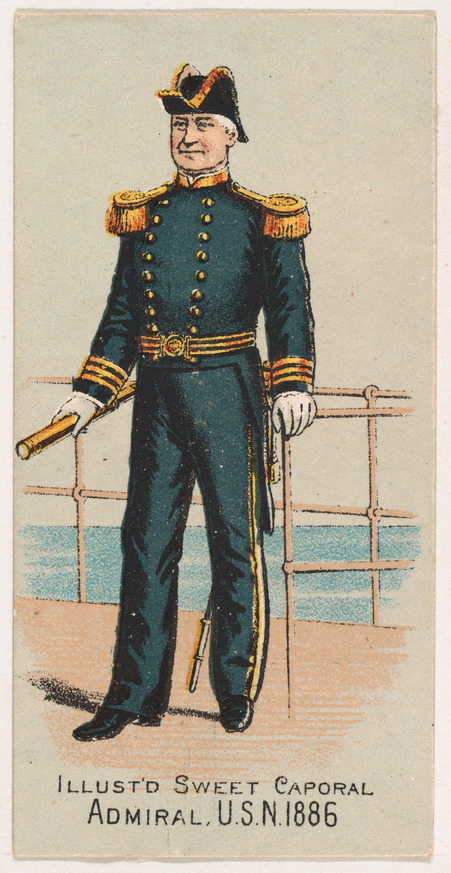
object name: print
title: Admiral, United States Navy, 1886, from the Military Series (N224) issued by Kinney Tobacco Company to promote Sweet Caporal Cigarettes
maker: kinney brothers tobacco company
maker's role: publisher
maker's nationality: american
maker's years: 1869-2011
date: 1888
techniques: color lithograph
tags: men,admirals